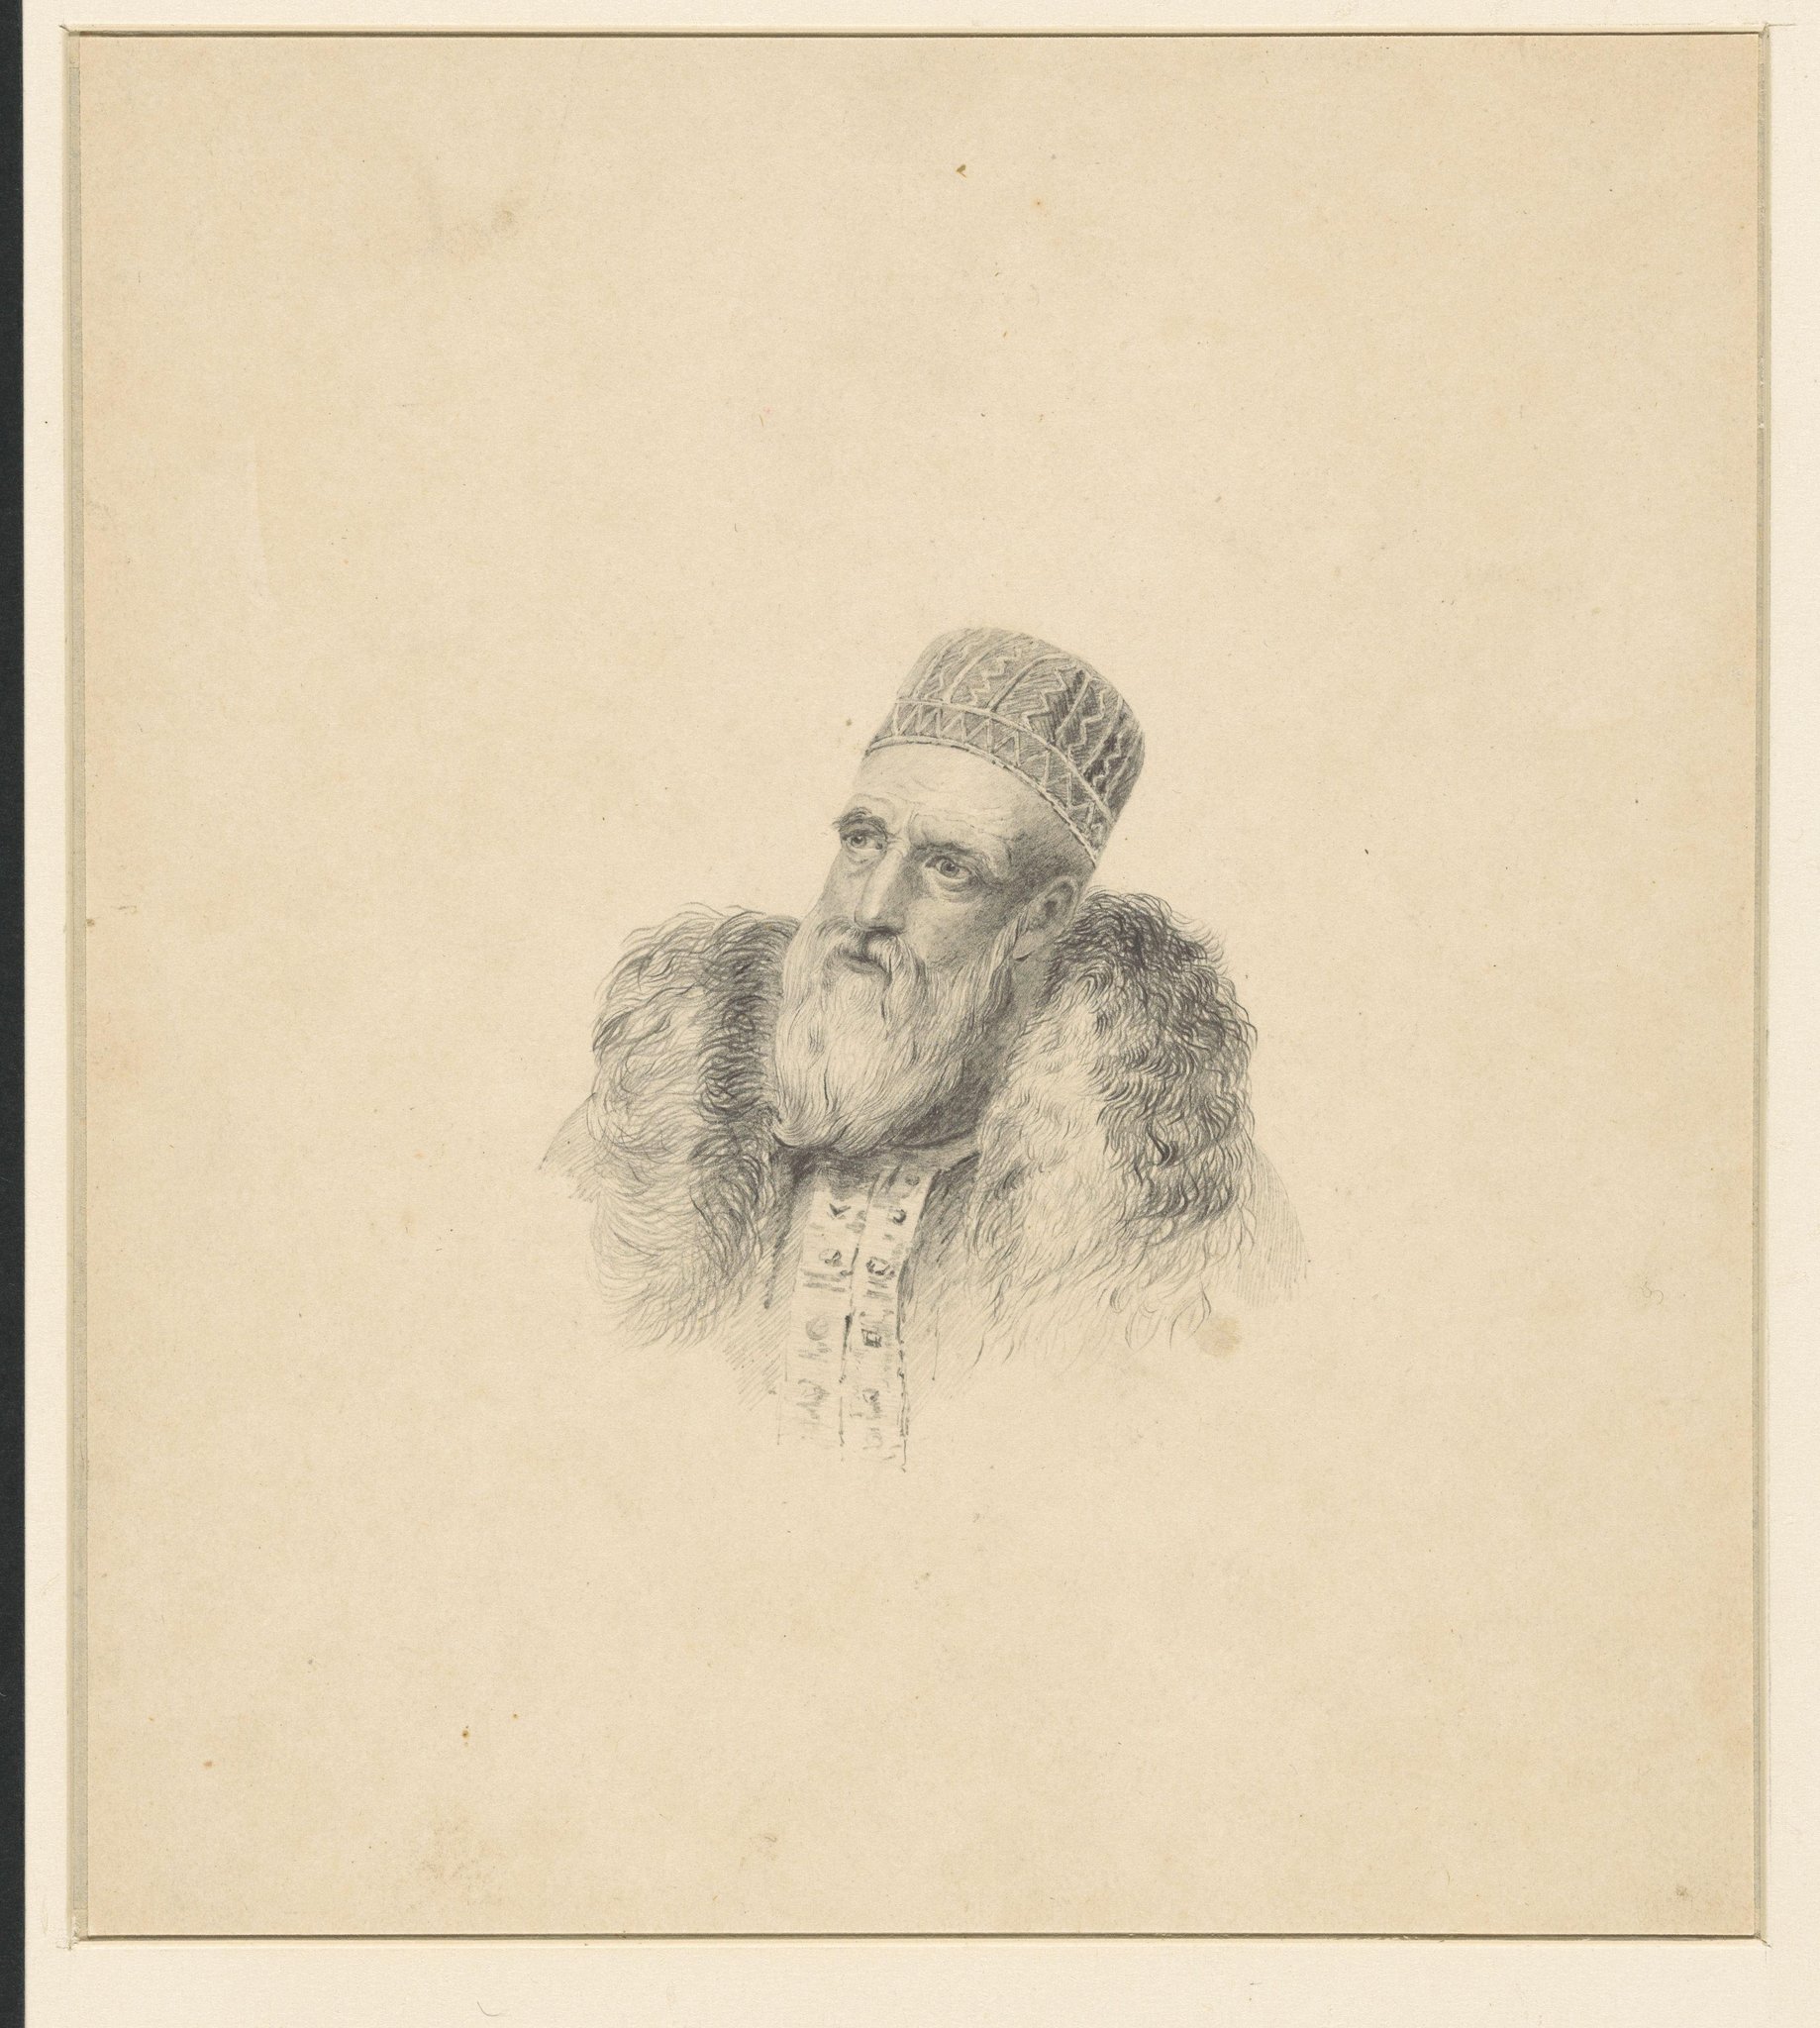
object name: drawing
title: Oude gebaarde man in 17de-eeuwse fantasiekleding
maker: Anonymous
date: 1800-1900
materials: paper, pencil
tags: old man